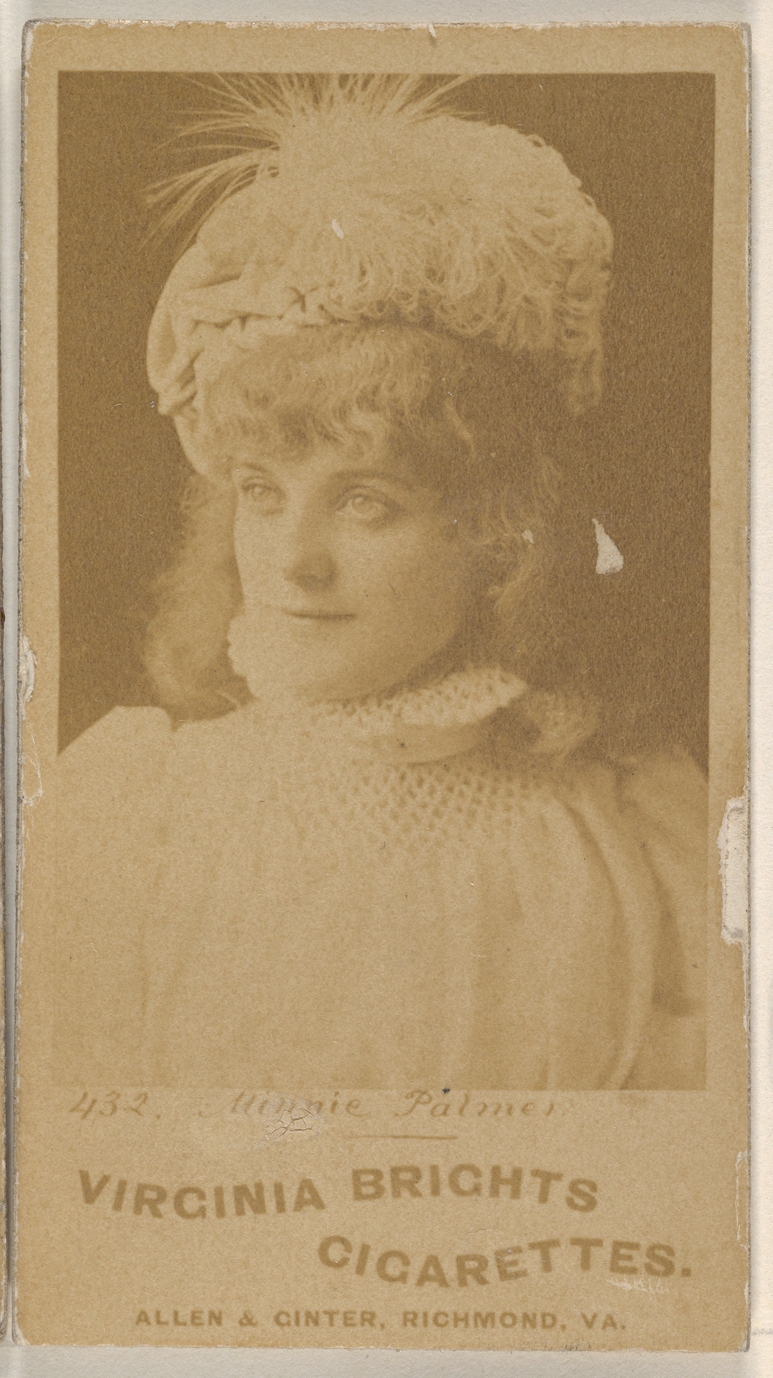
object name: photograph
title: Card 432, Minnie Palmer, from the Actors and Actresses series (N45, Type 1) for Virginia Brights Cigarettes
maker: allen & ginter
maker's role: publisher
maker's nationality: american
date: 1888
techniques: albumen silver print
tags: portraits,women,actresses